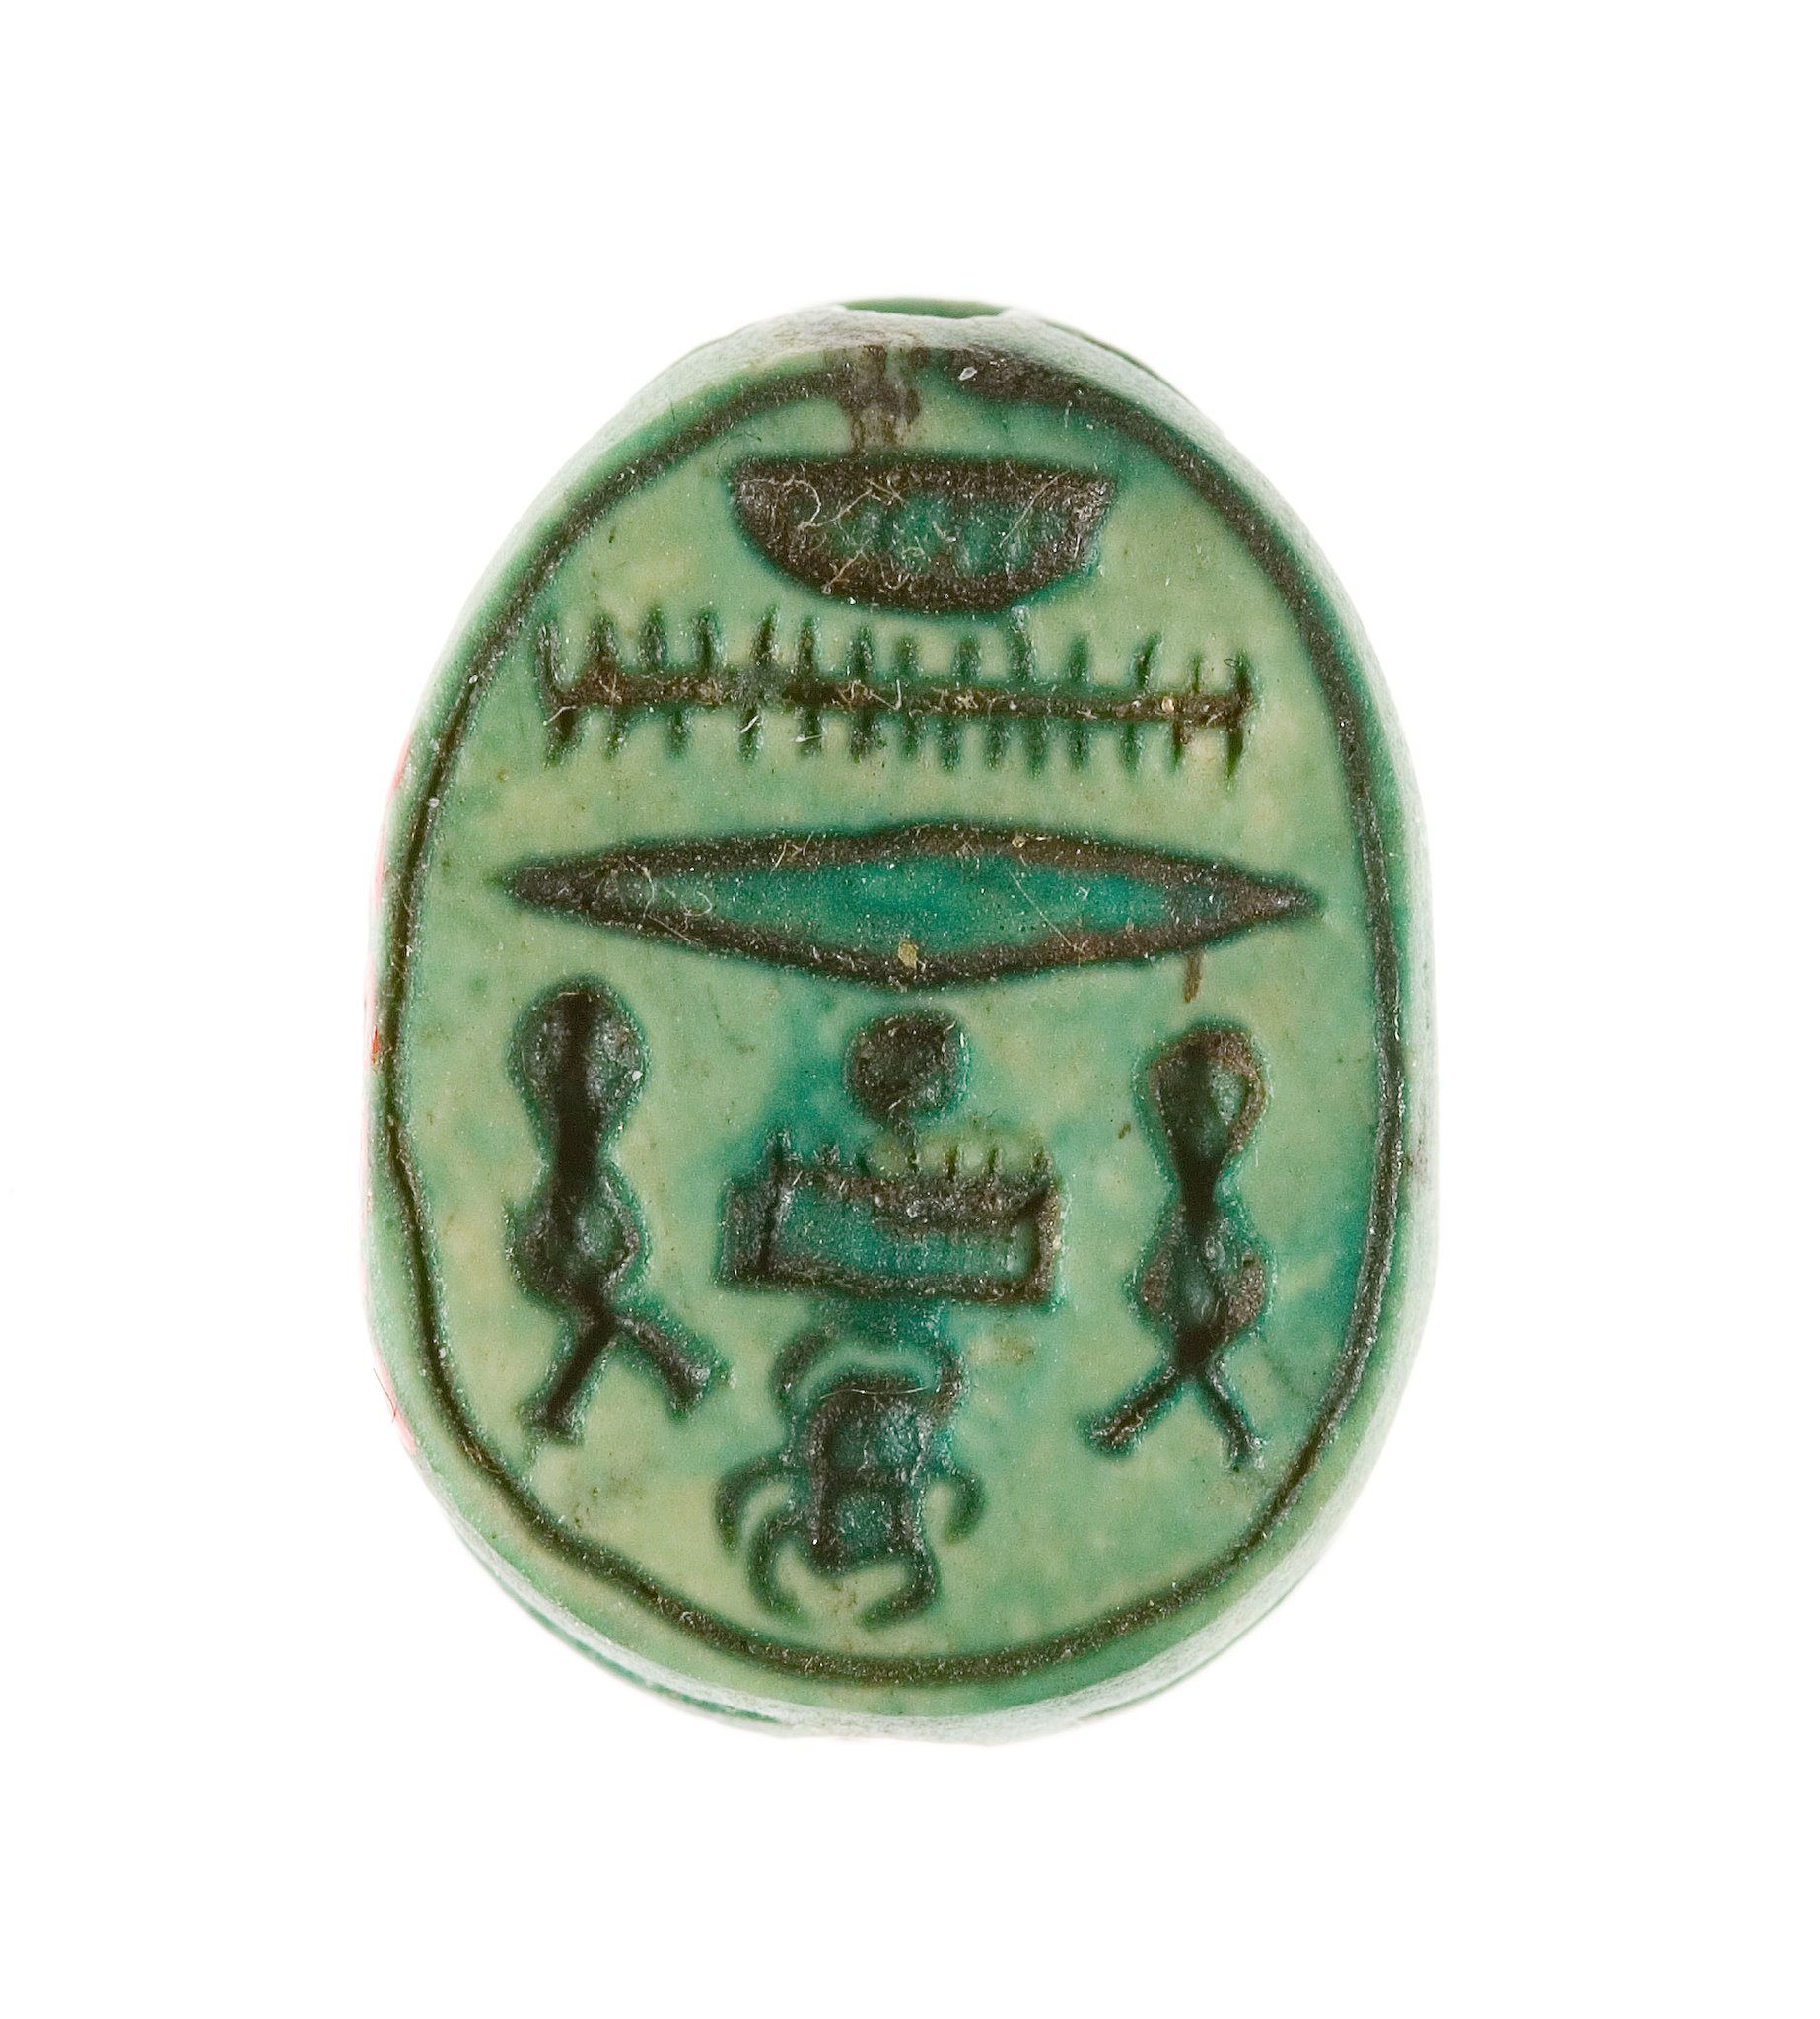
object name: scarab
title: Scarab Inscribed with the Throne Name of Thutmose III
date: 1479-1458 BCE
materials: stone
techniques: glazing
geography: egypt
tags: hieroglyphs,scarabs